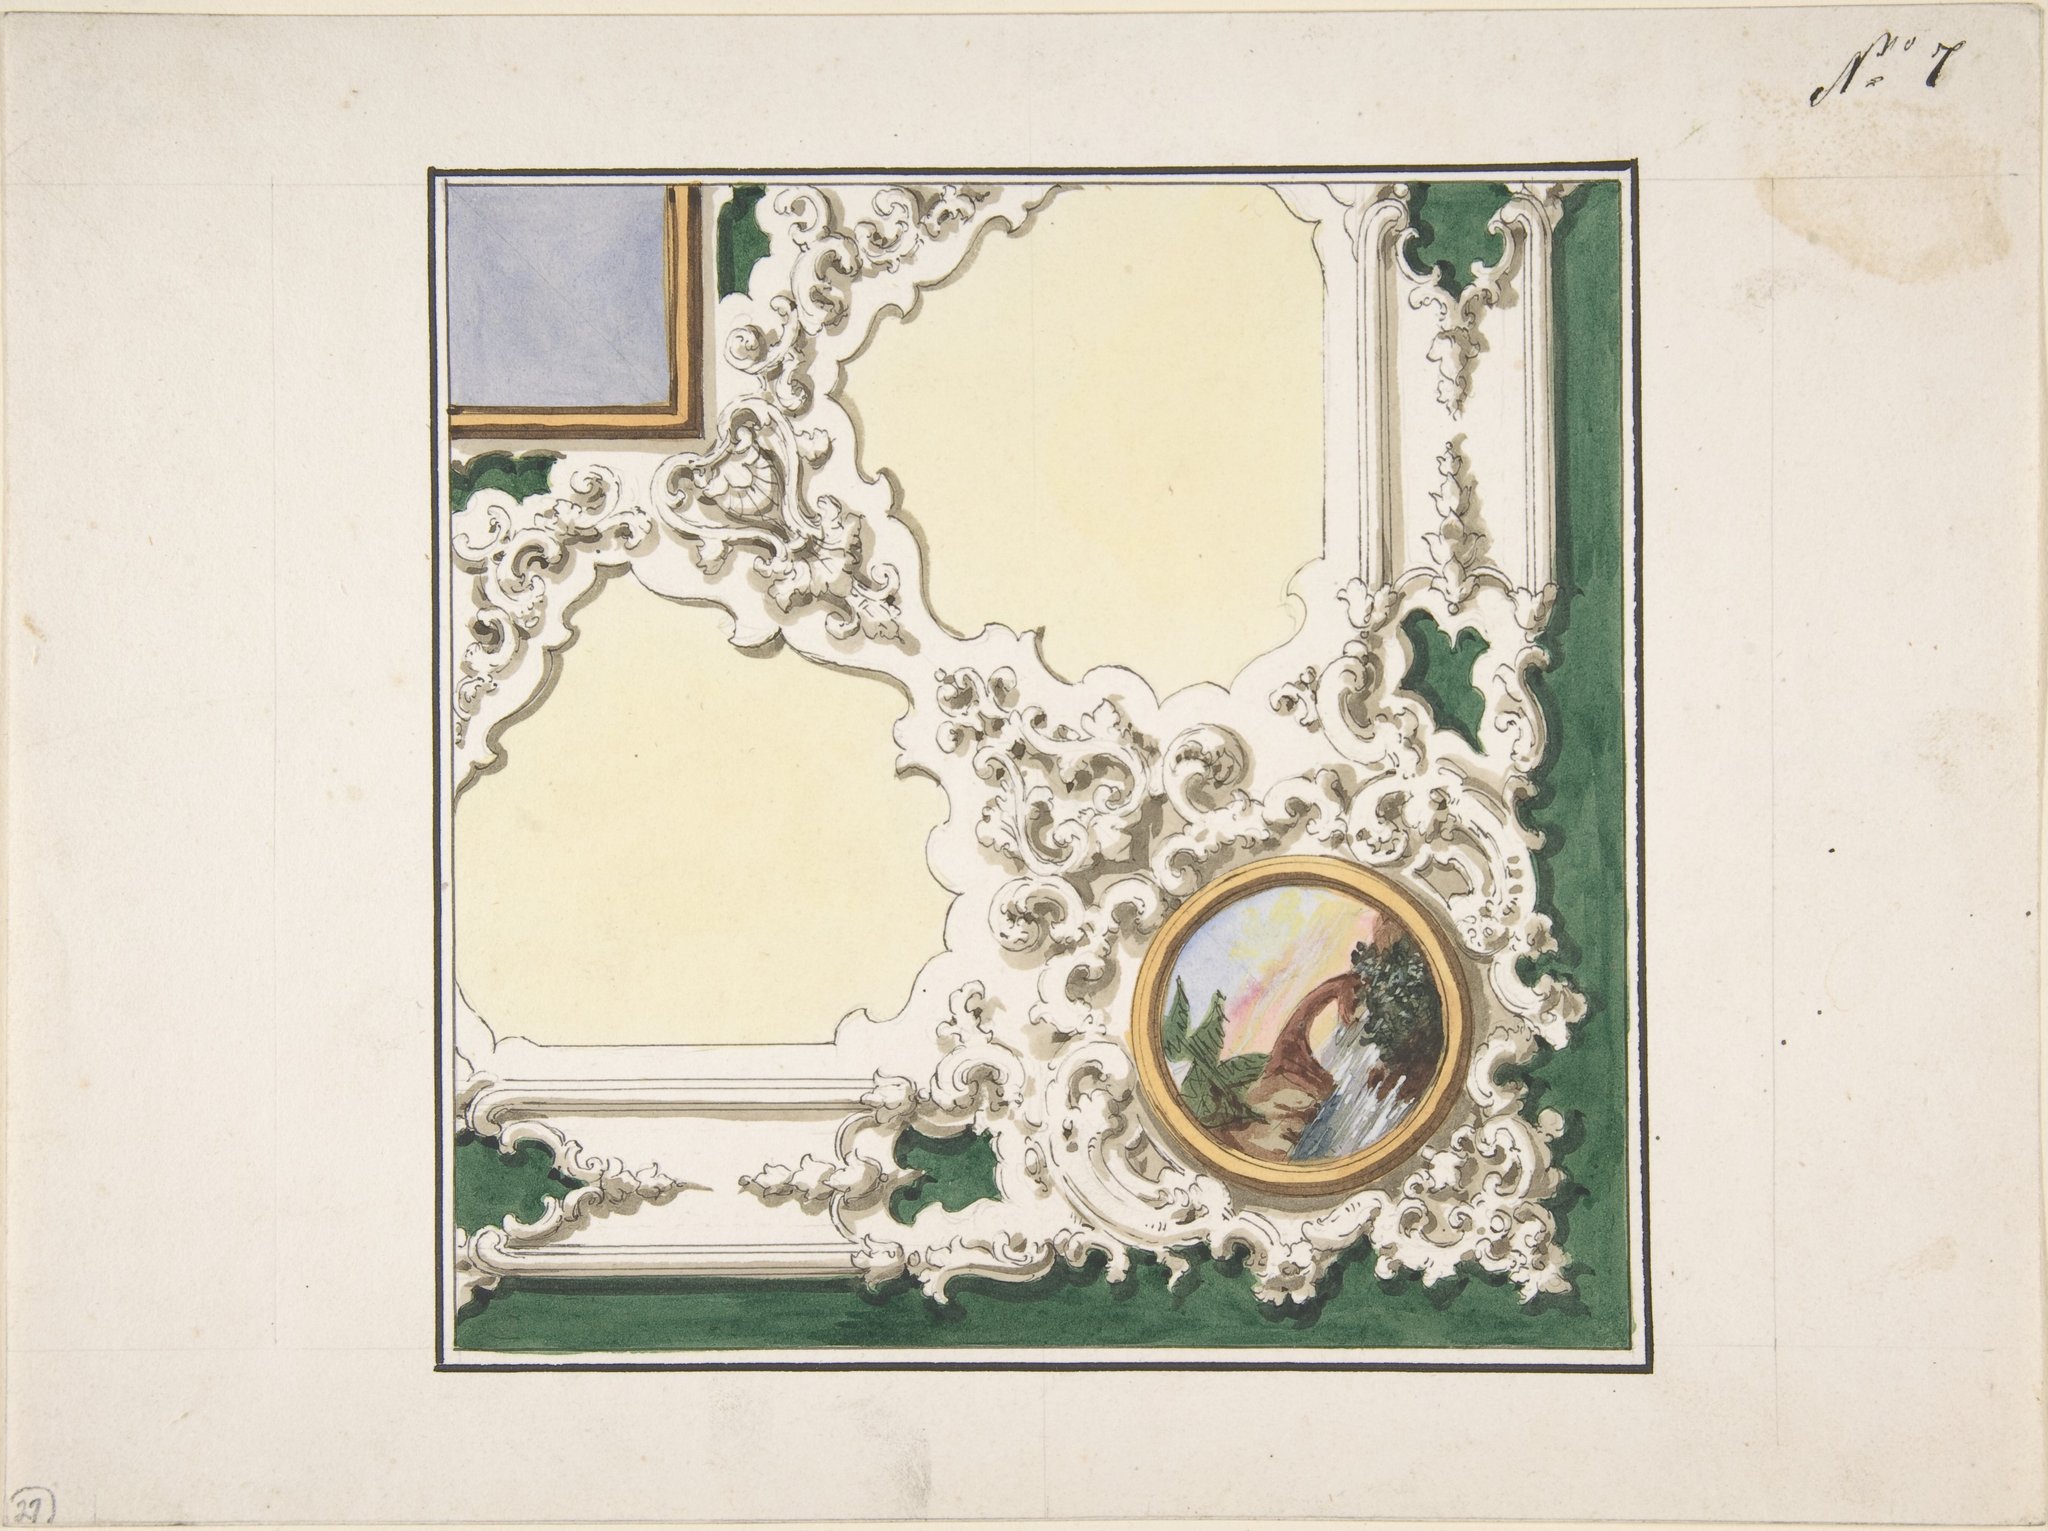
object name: drawing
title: Design for Ceiling Decoration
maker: anonymous, italian, 19th century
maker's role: artist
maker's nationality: italian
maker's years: 1800-1900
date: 1850-1870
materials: watercolor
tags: ceilings